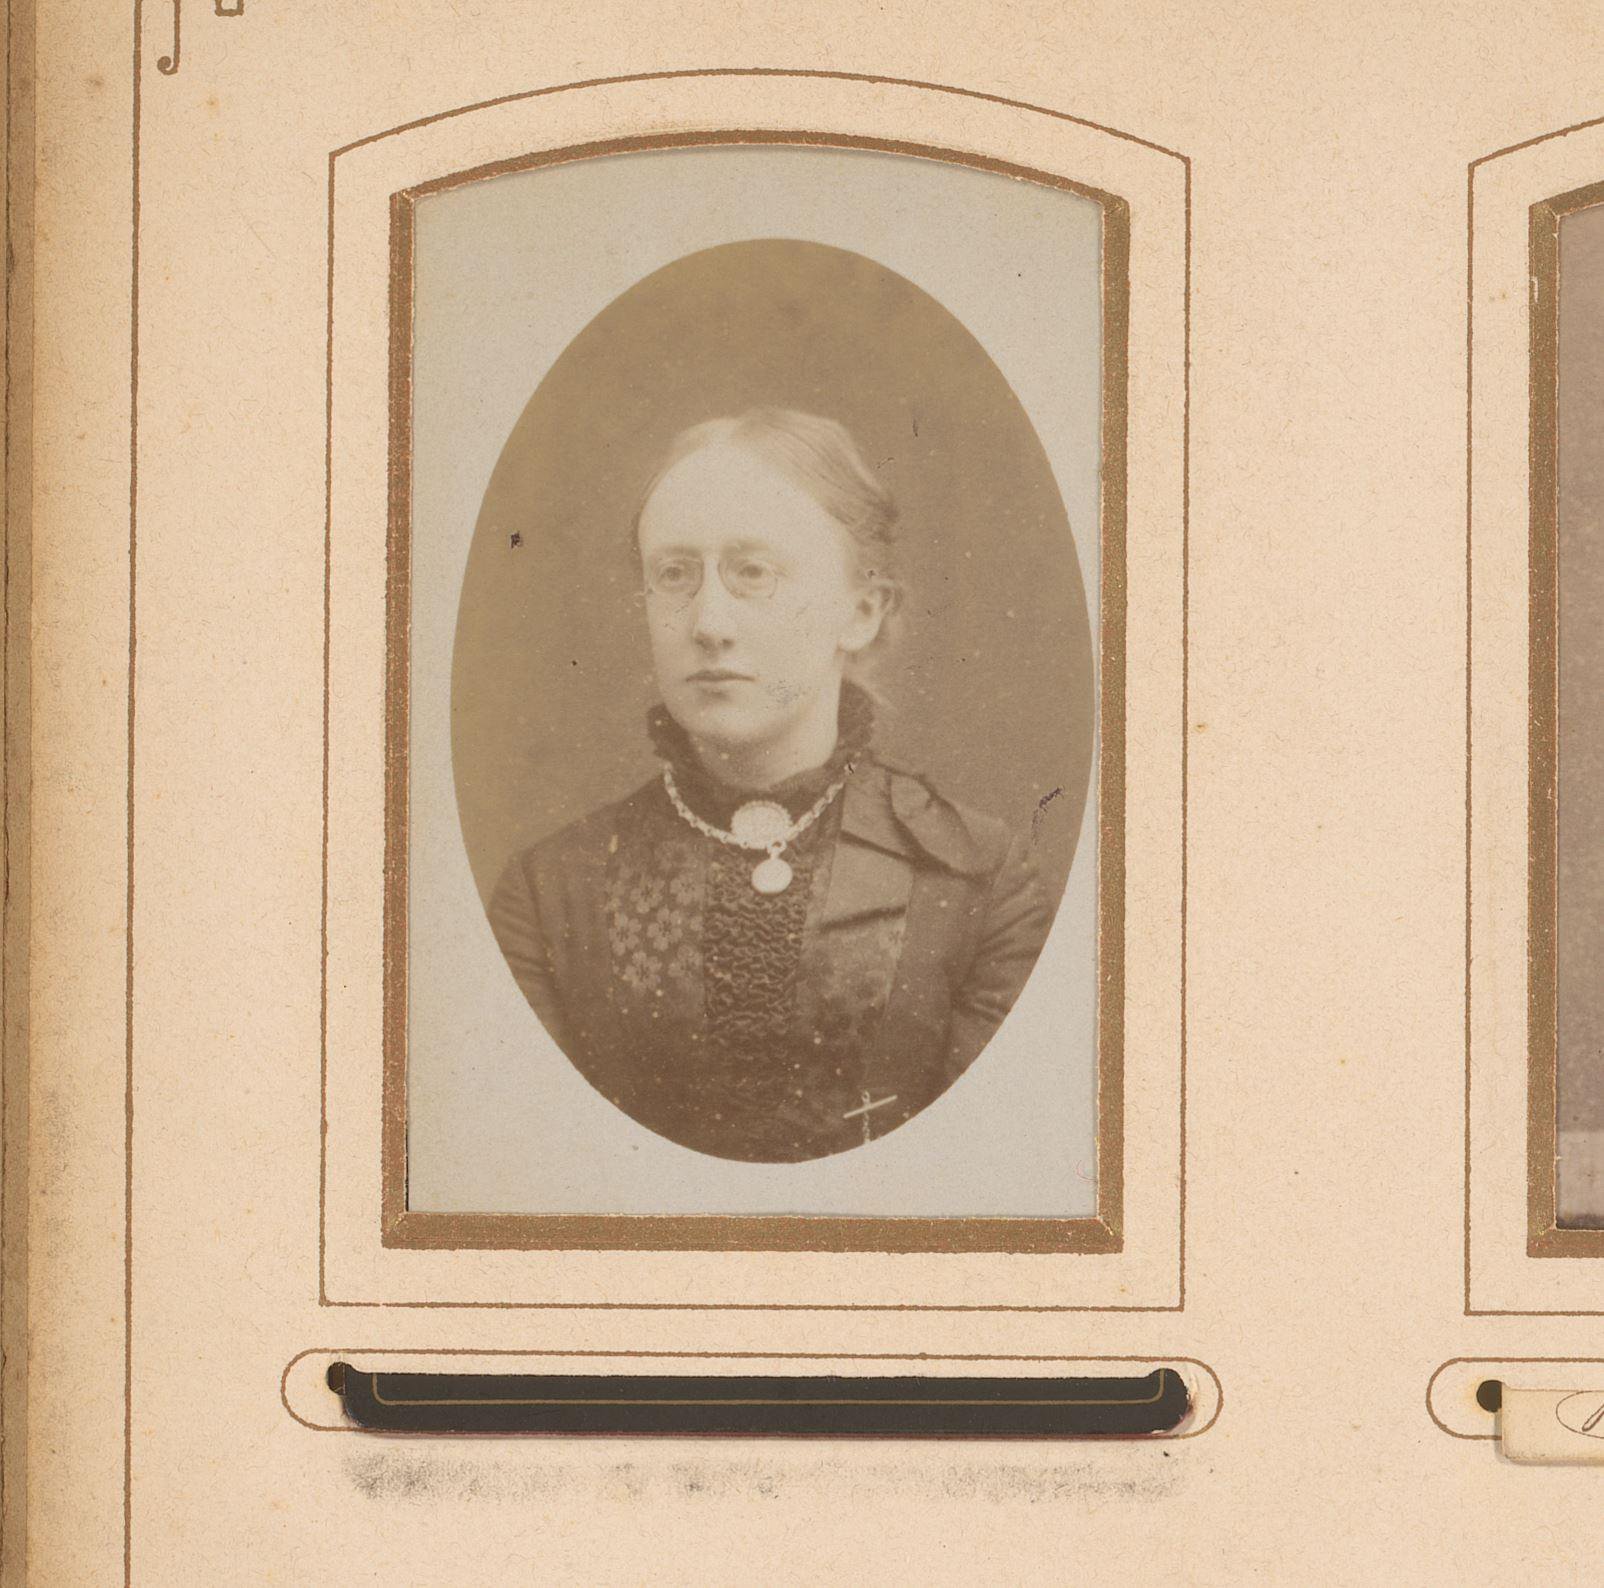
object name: album leaf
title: Portret van een vrouw met bril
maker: adolphe zimmermans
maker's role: fotograaf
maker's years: 1858-1922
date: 1879-1883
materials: cardboard, photographic support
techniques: albumen print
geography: the hague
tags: eyeglasses, spectacles, historical persons - bb - woman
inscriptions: inscription: ‘Riemerstraat No 48/ La Haye’